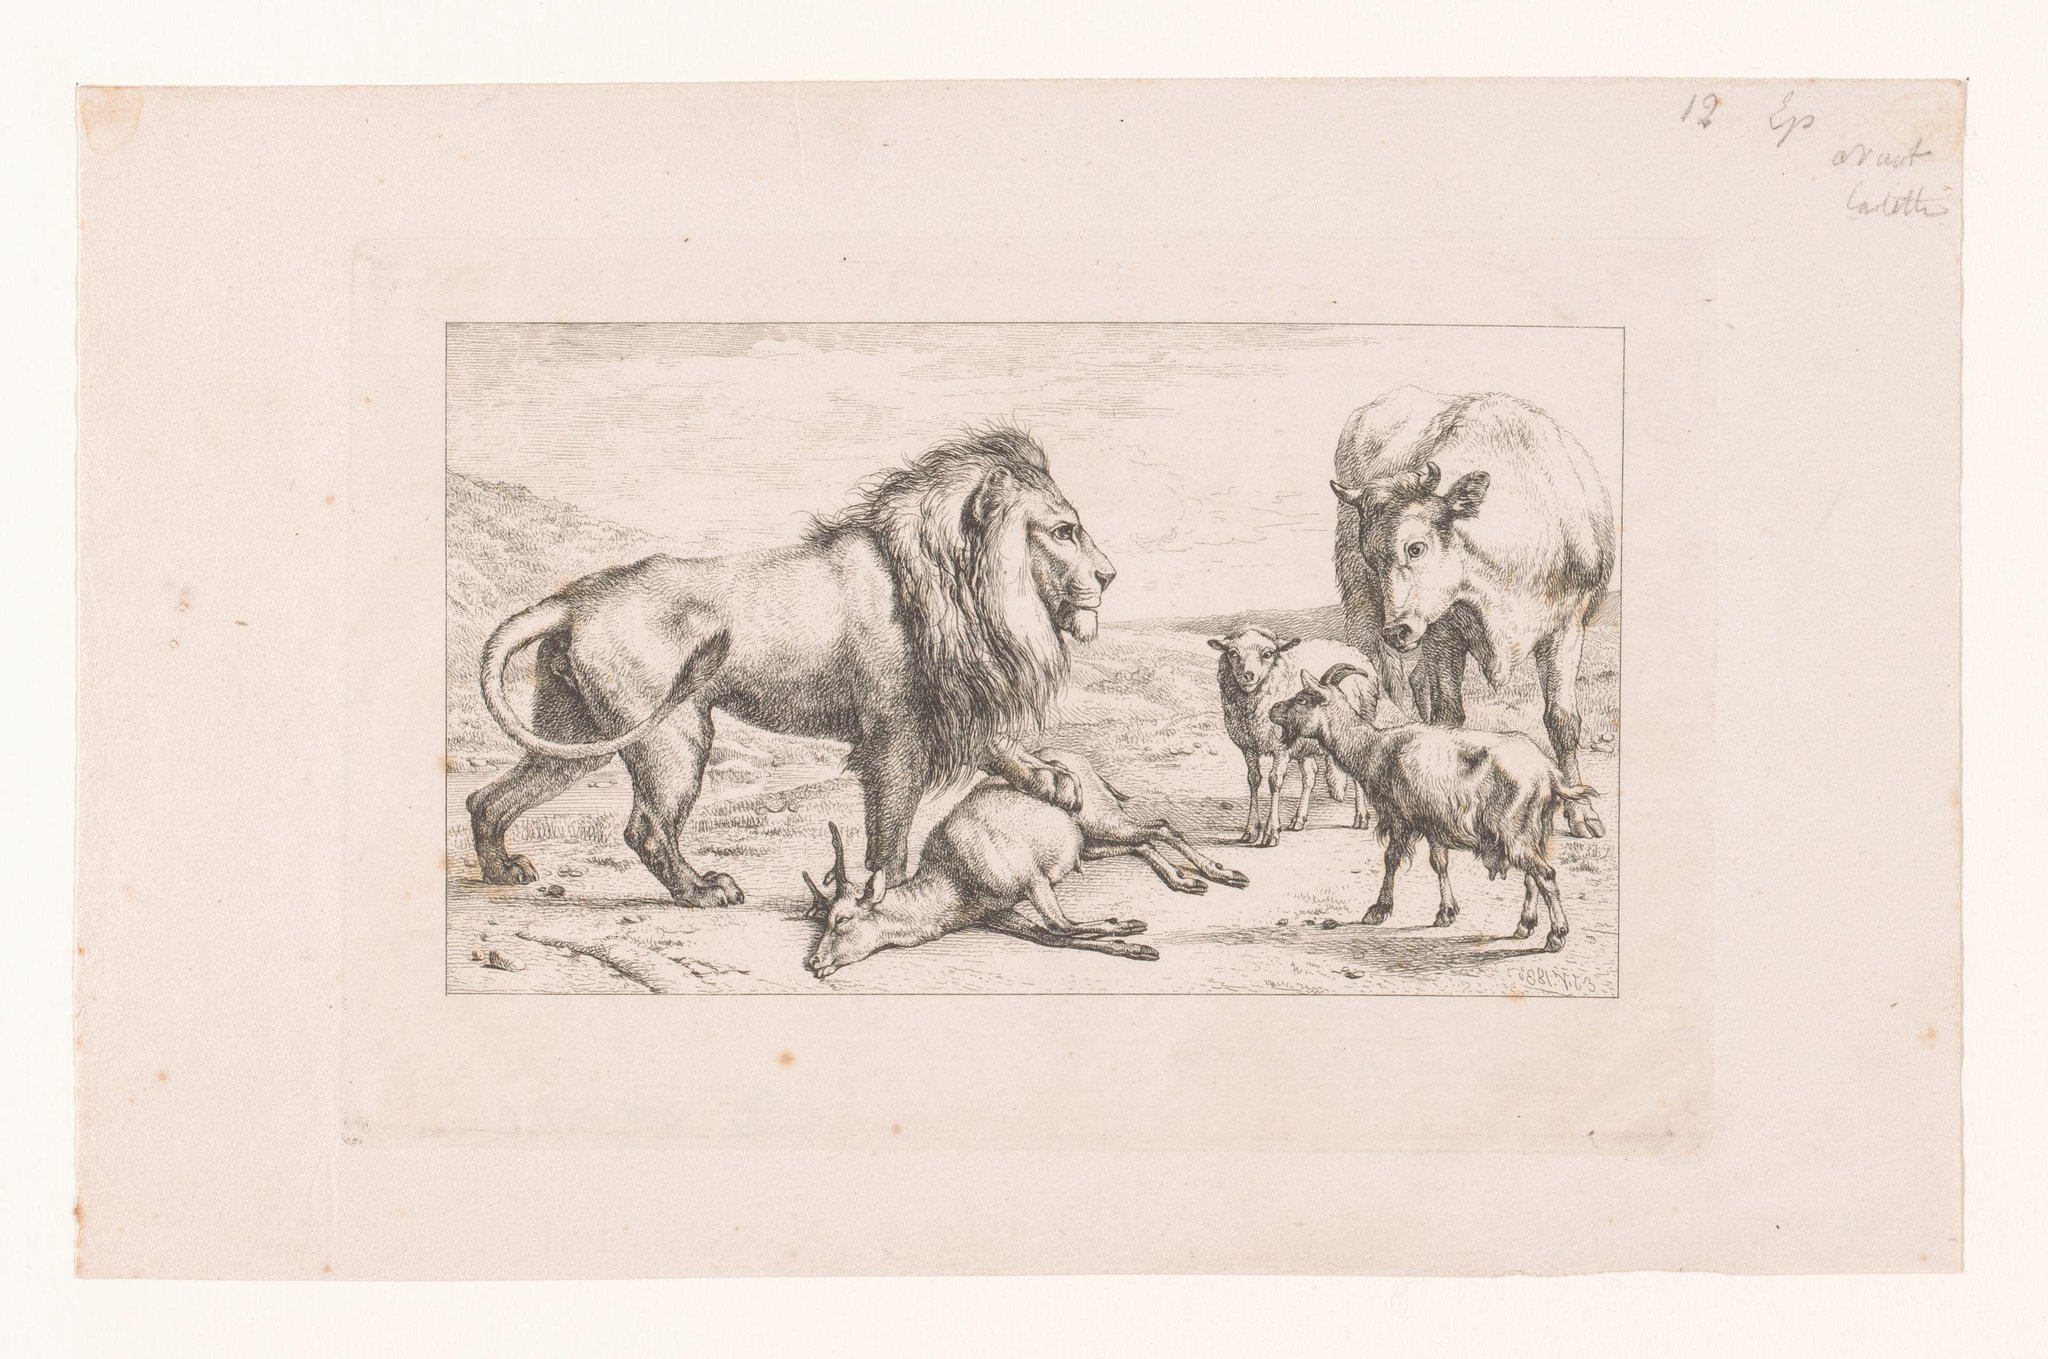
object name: print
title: Fabels van La Fontaine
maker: eugène verboeckhoven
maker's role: draughtsman, painter, print maker, printer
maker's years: 1798-1881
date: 1830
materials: paper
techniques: etching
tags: fables, beasts of prey, predatory animals: lion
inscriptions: date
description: Fabel van de leeuw, koe, schaap en geit die een bondgenootschap hebben gesloten. Als er een hert gevangen wordt, weet de leeuw alsnog ieders deel van de vangst op te eisen